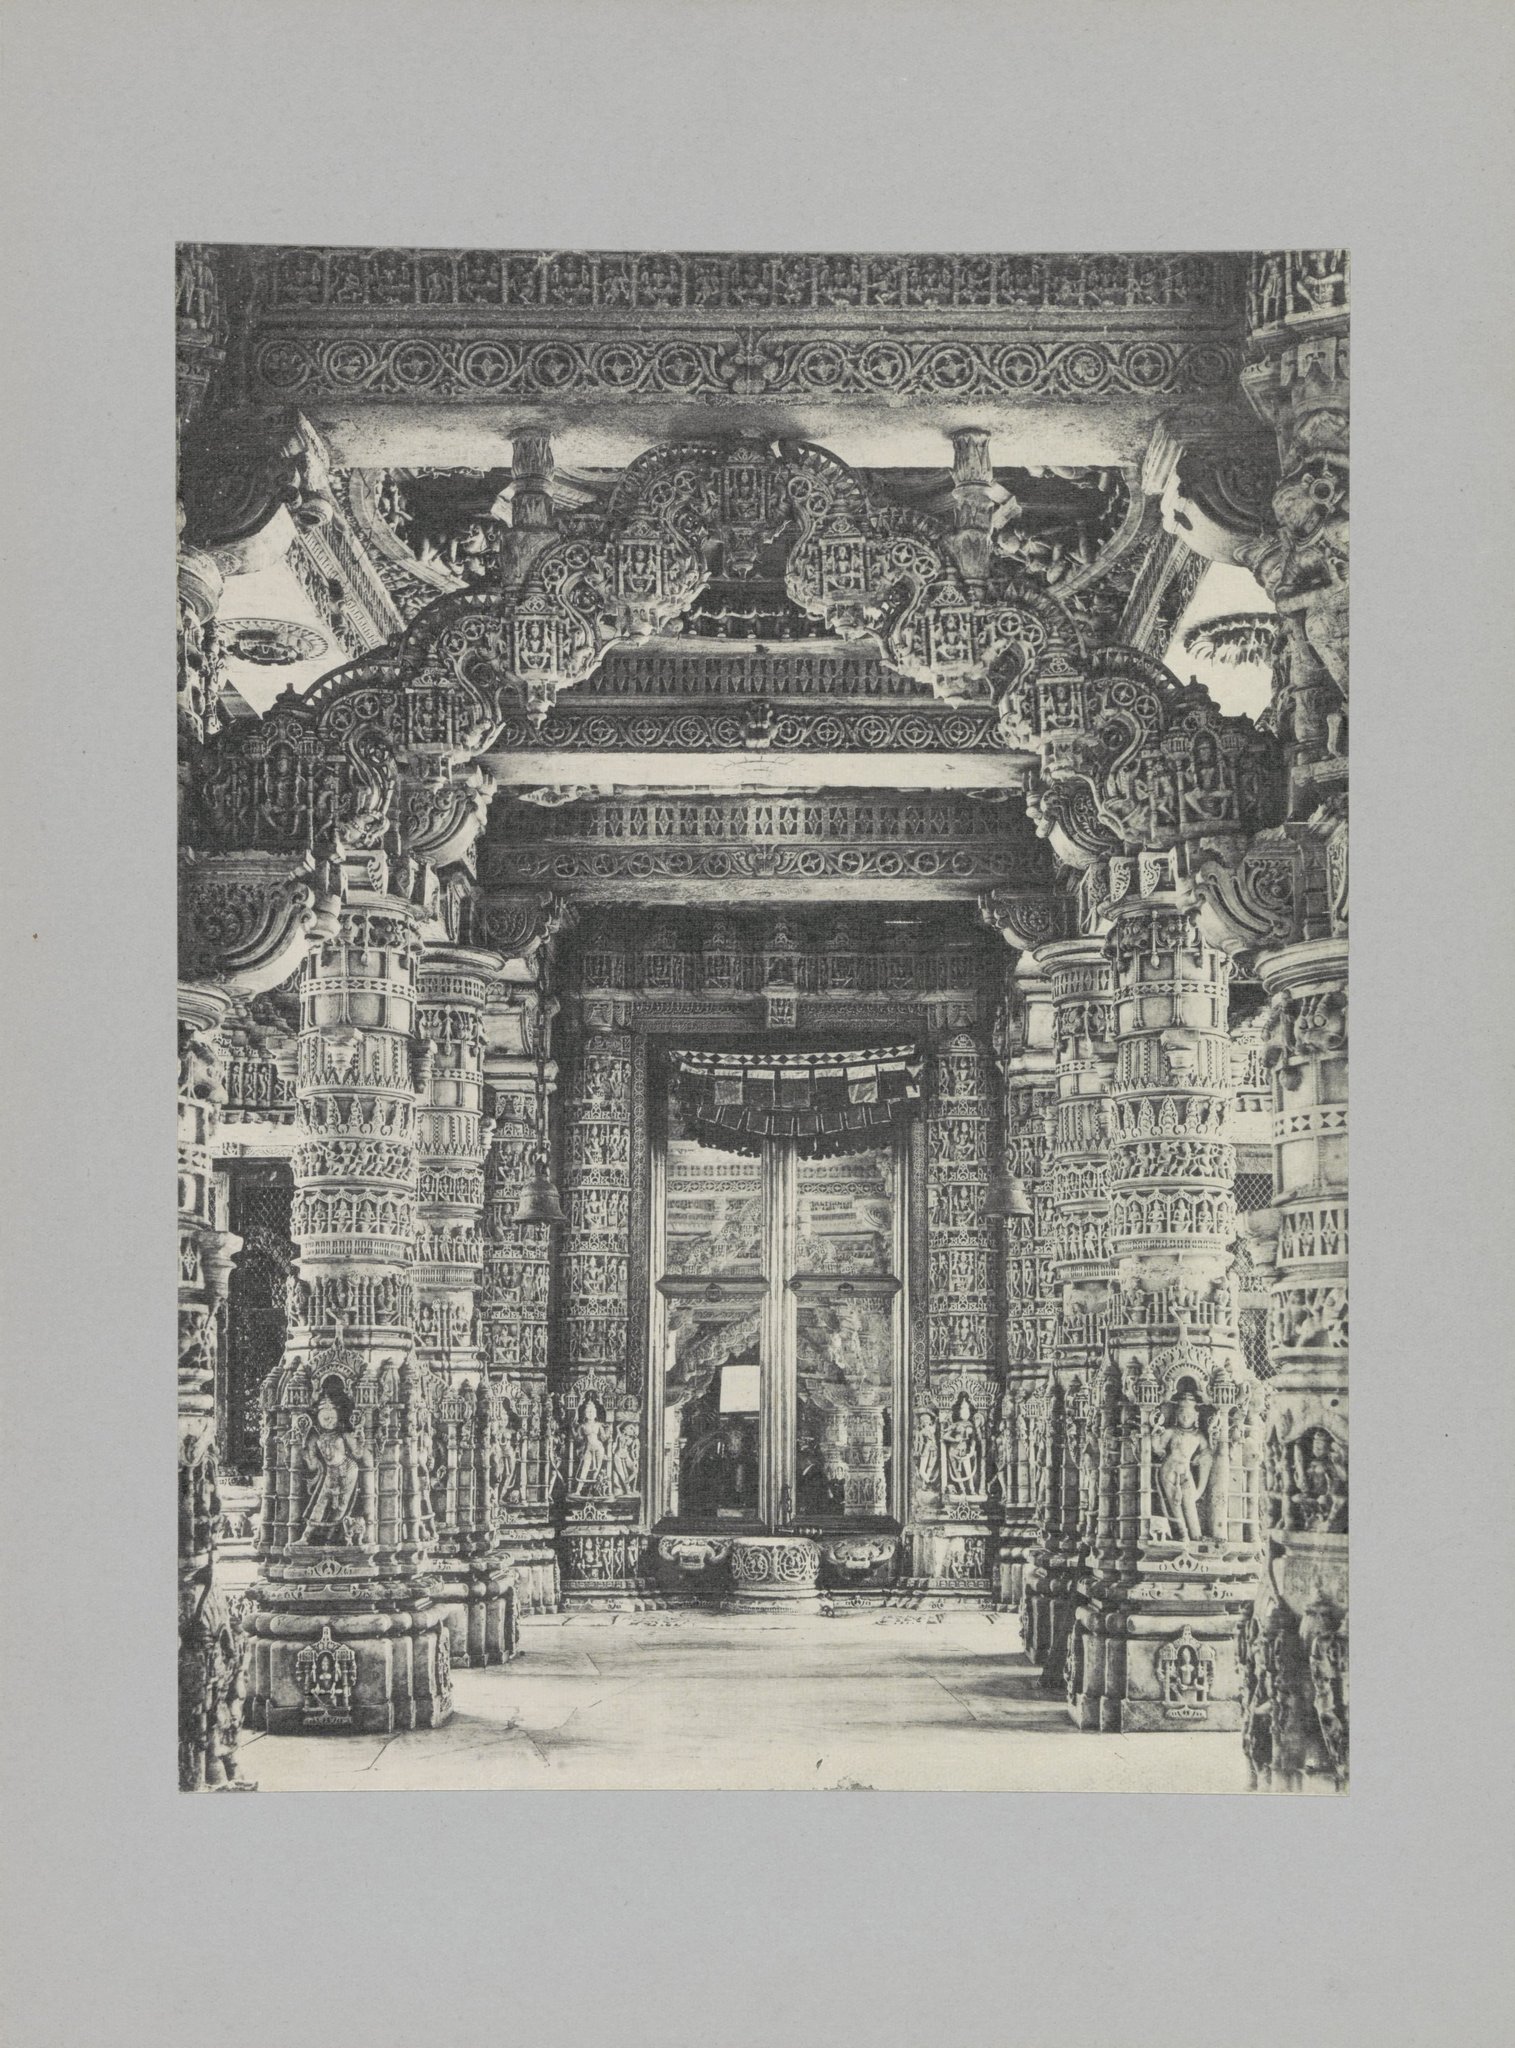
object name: photomechanical print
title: Interior of the Dilwara Temple at Mount Abu, Rajasthan, India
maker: Anonymous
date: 1895-1915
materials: cardboard, paper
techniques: photograph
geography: mount abu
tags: rajasthan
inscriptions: annotation: ‘68. Tempel te Dilwarra bij Mount Abu.’